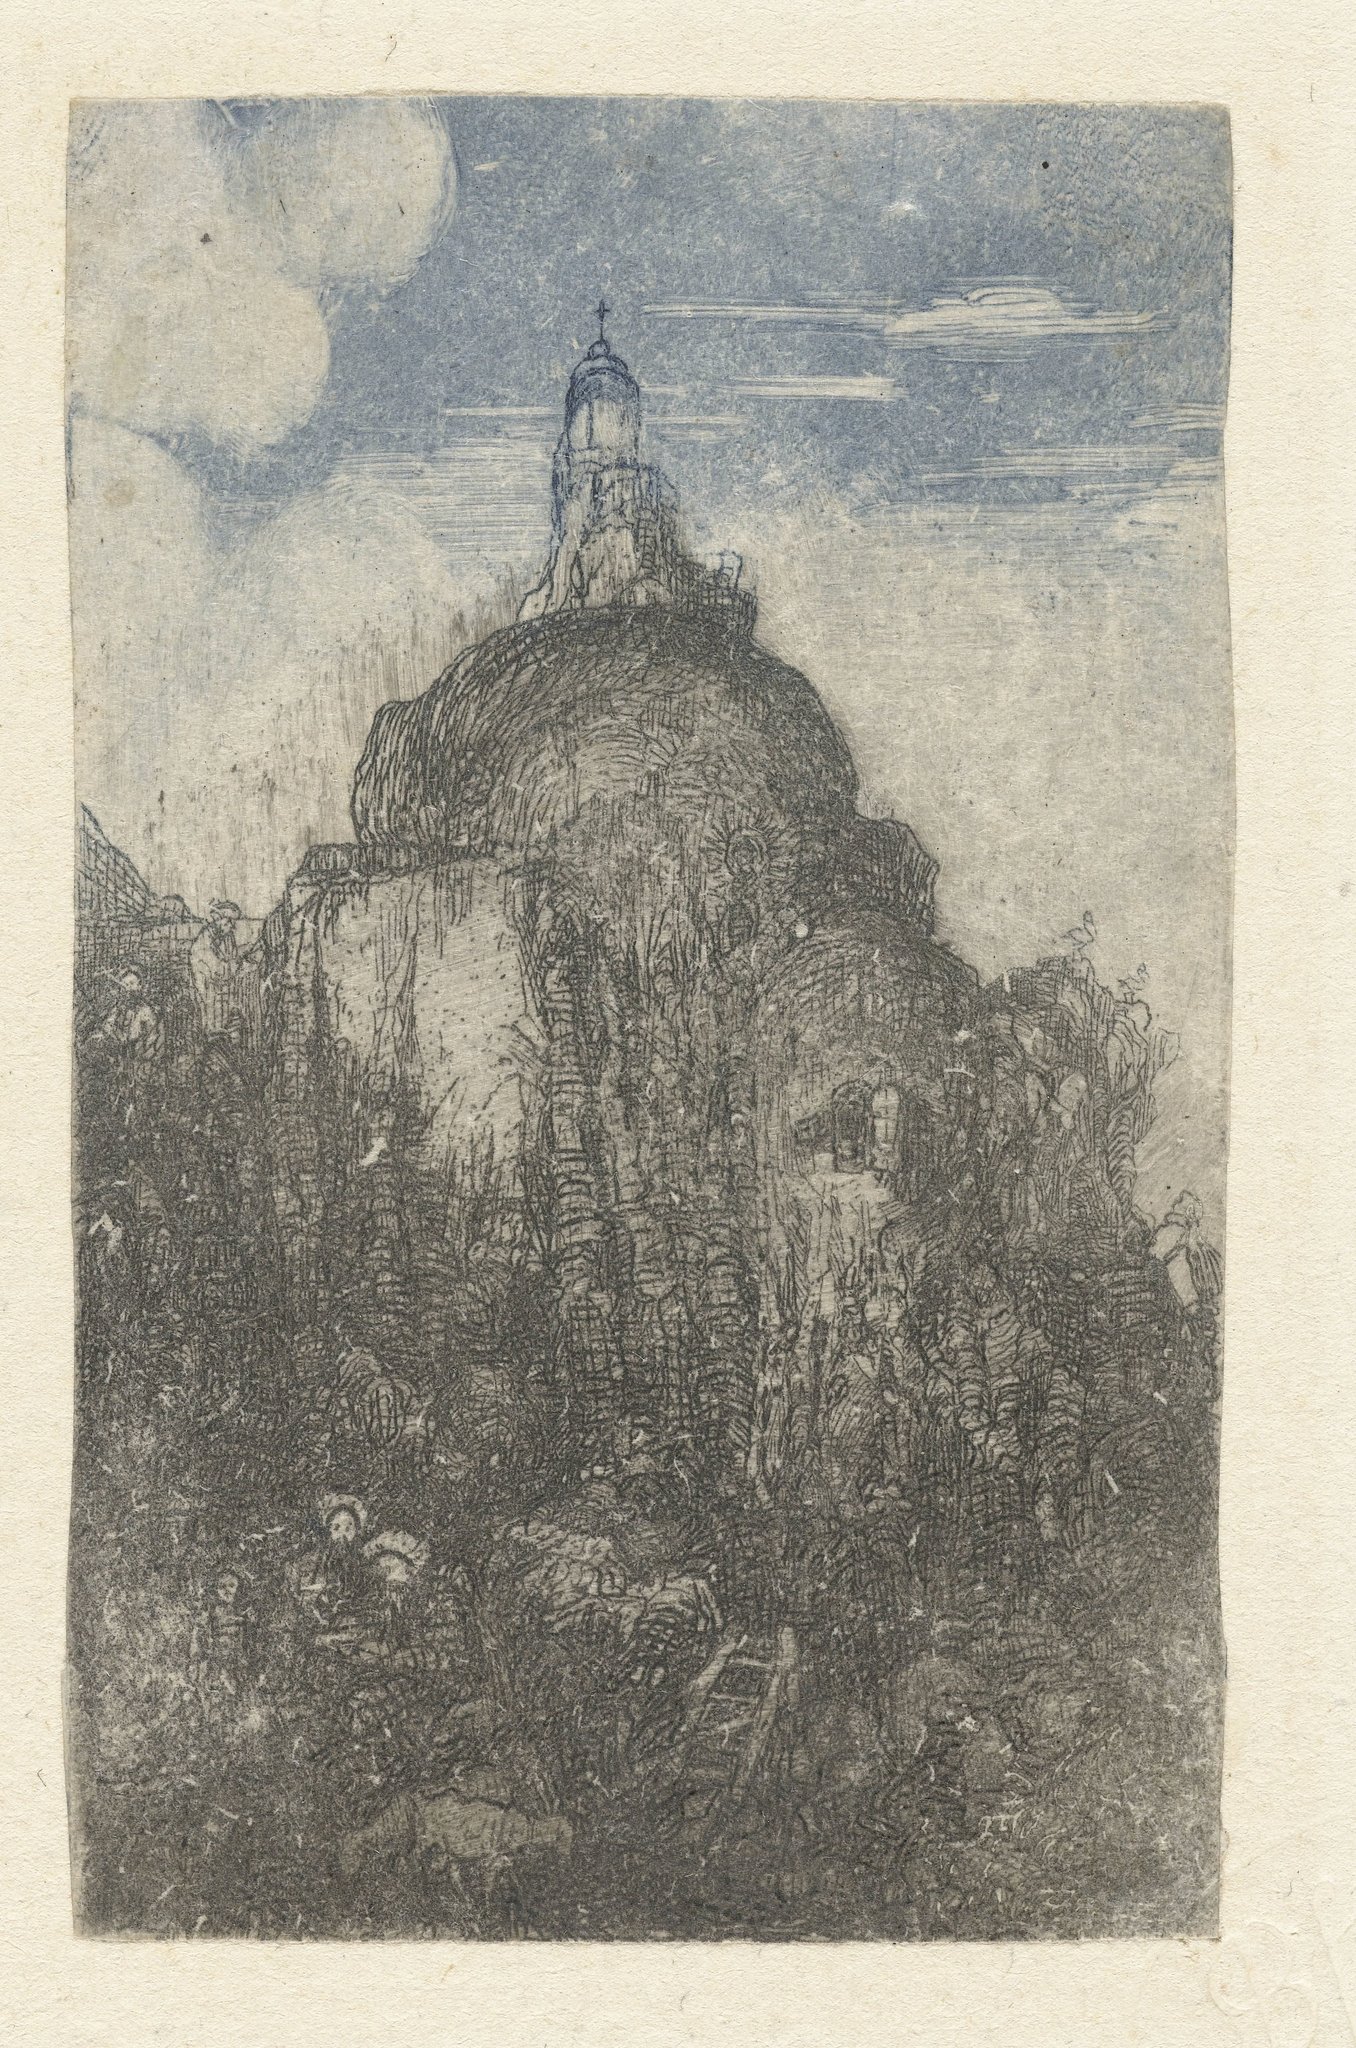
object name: print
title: Chapelle alpestre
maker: rodolphe bresdin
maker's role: draughtsman, print maker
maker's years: 1822-1885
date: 1844-1849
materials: paper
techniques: etching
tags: lighthouse, lightship, rocky coast, church (exterior), rocks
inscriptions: collector's mark: Lugt 2194, collector's mark: Lugt 2760, inscription: ‘Acheté de Paul Bresdin/ 6/5/29 P. et R. Nice’, collector's mark: Lugt 2228, collector's mark: Lugt 2069a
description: Op een hoge rots staat een gebouw met een kruis bovenop een koepeldak. Mogelijk is het een vuurtoren of een kapel. Aan de voet van de rots zitten twee herders met schapen. Rechts op een rots zitten twee vogels. Deze ets is met twee platen gedrukt waarbij Bresdin ervoor koos om de lucht blauw te kleuren.